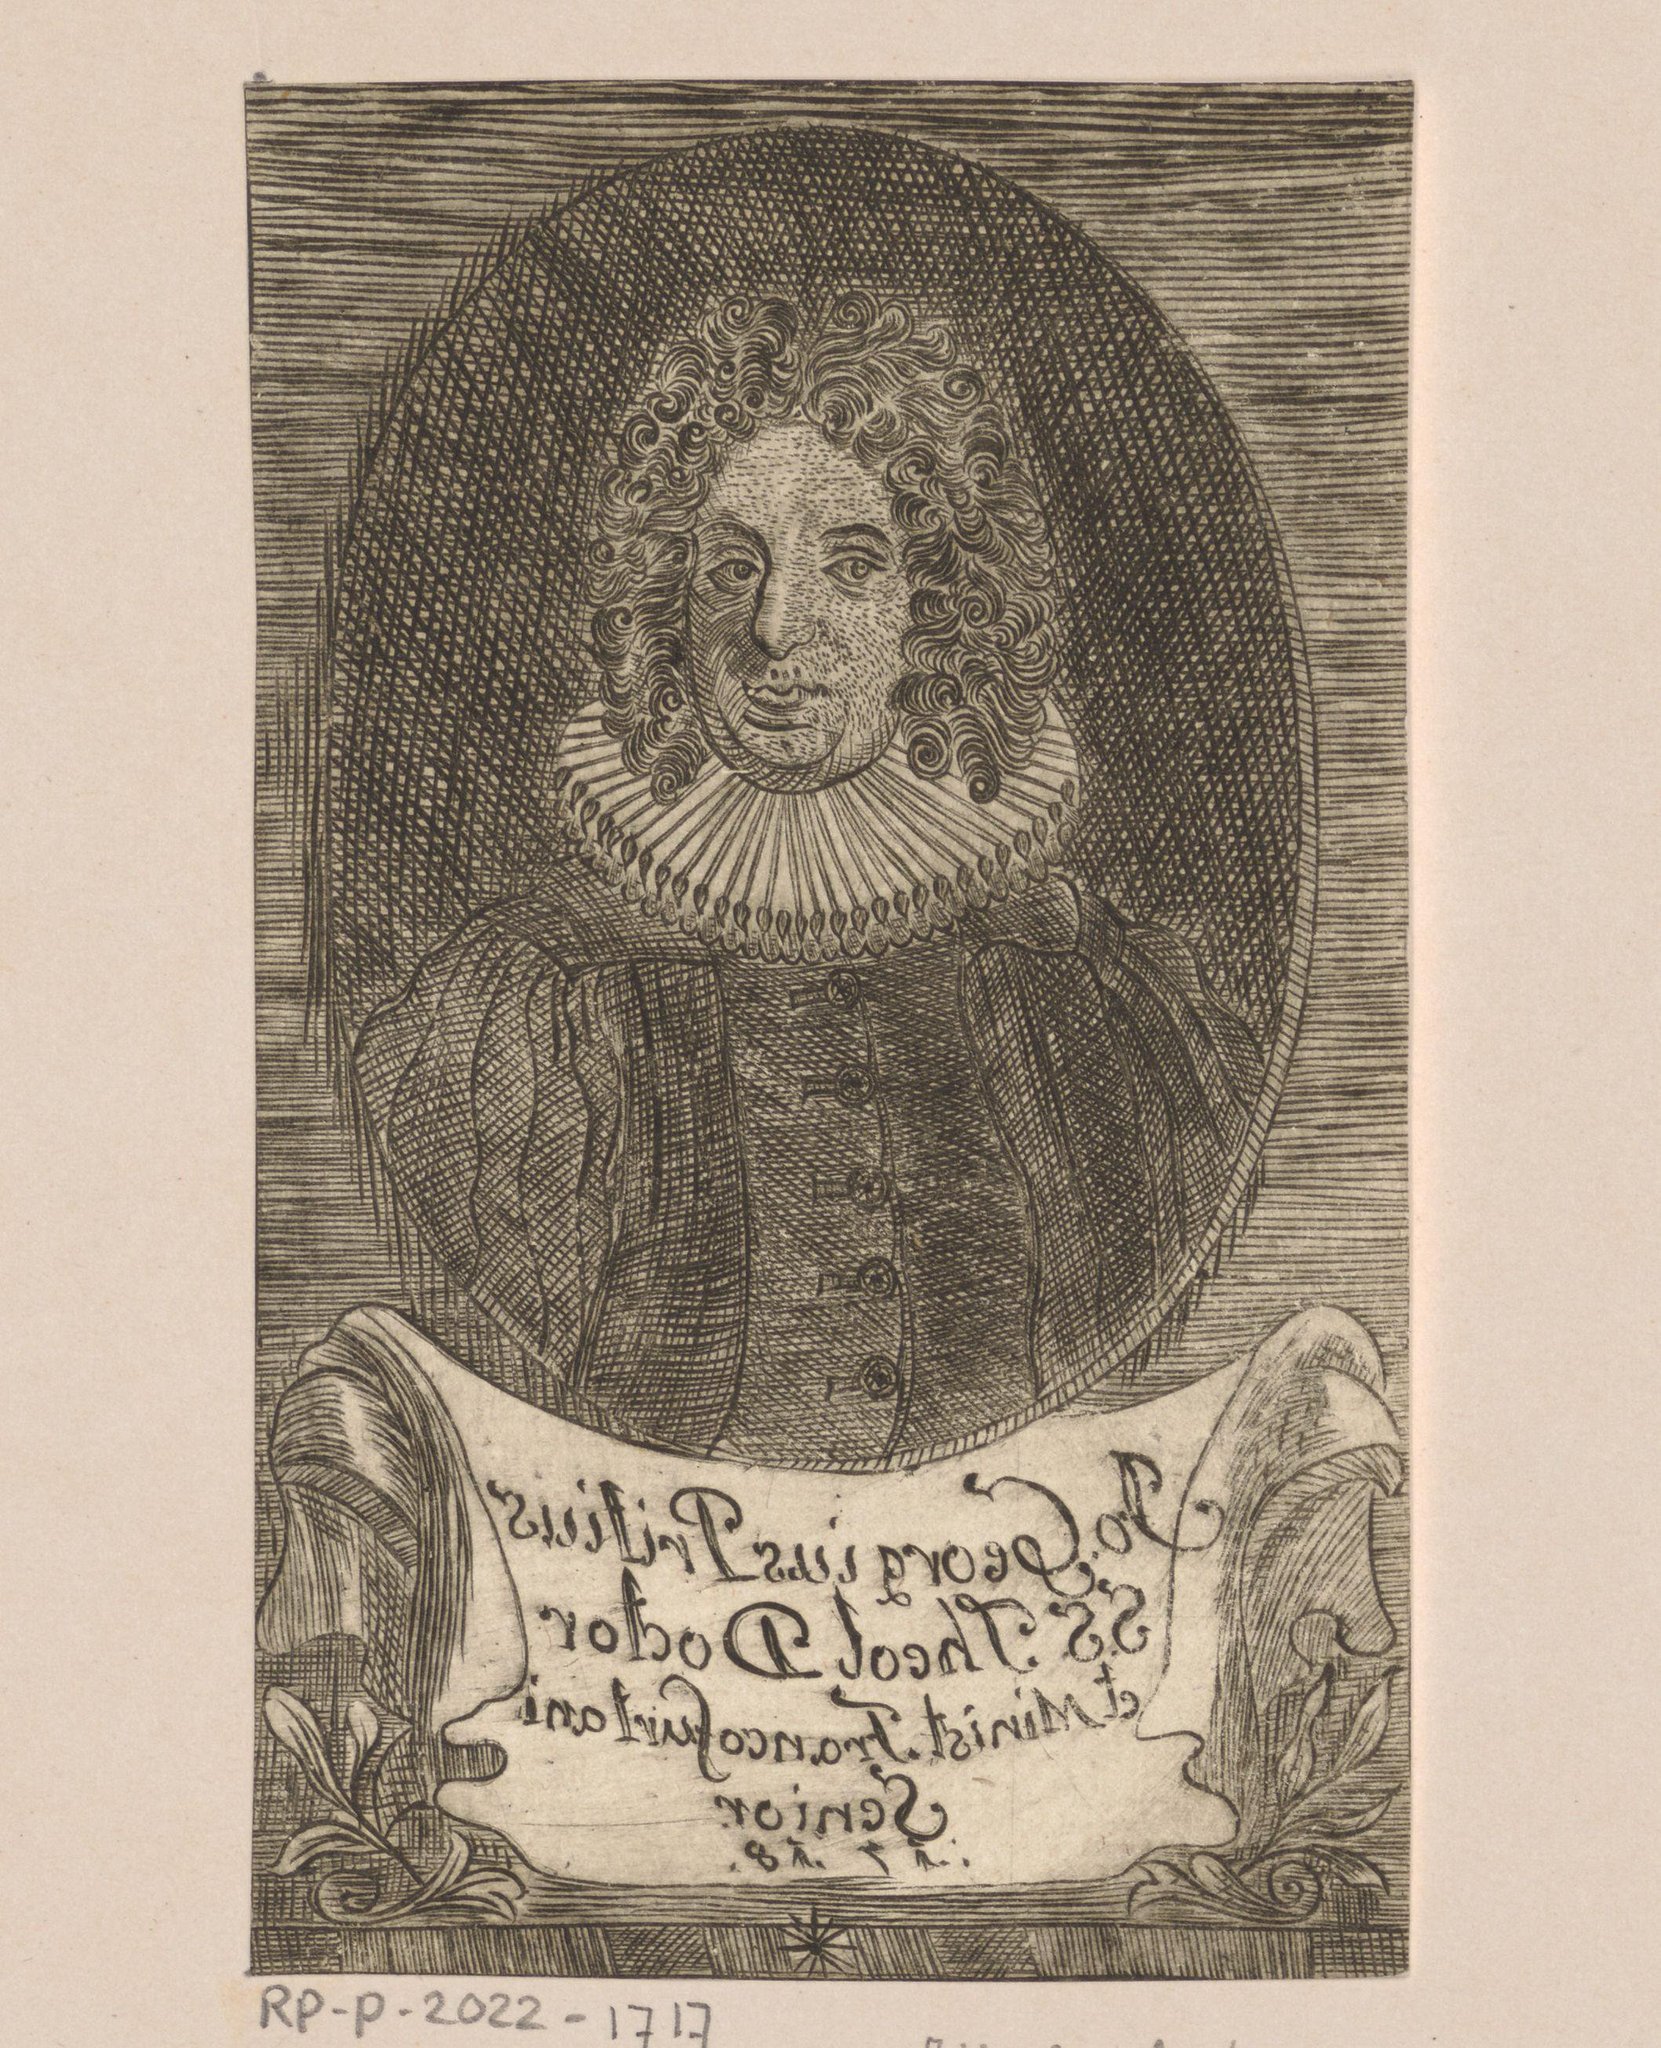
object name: print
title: Portret van Johann Georg Pritius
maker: Anonymous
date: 1718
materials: paper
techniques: engraving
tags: johann georg pritius, theologian, historical persons, portrait of a writer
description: Met vierregelig onderschrift in spiegelbeeld in het Latijn.